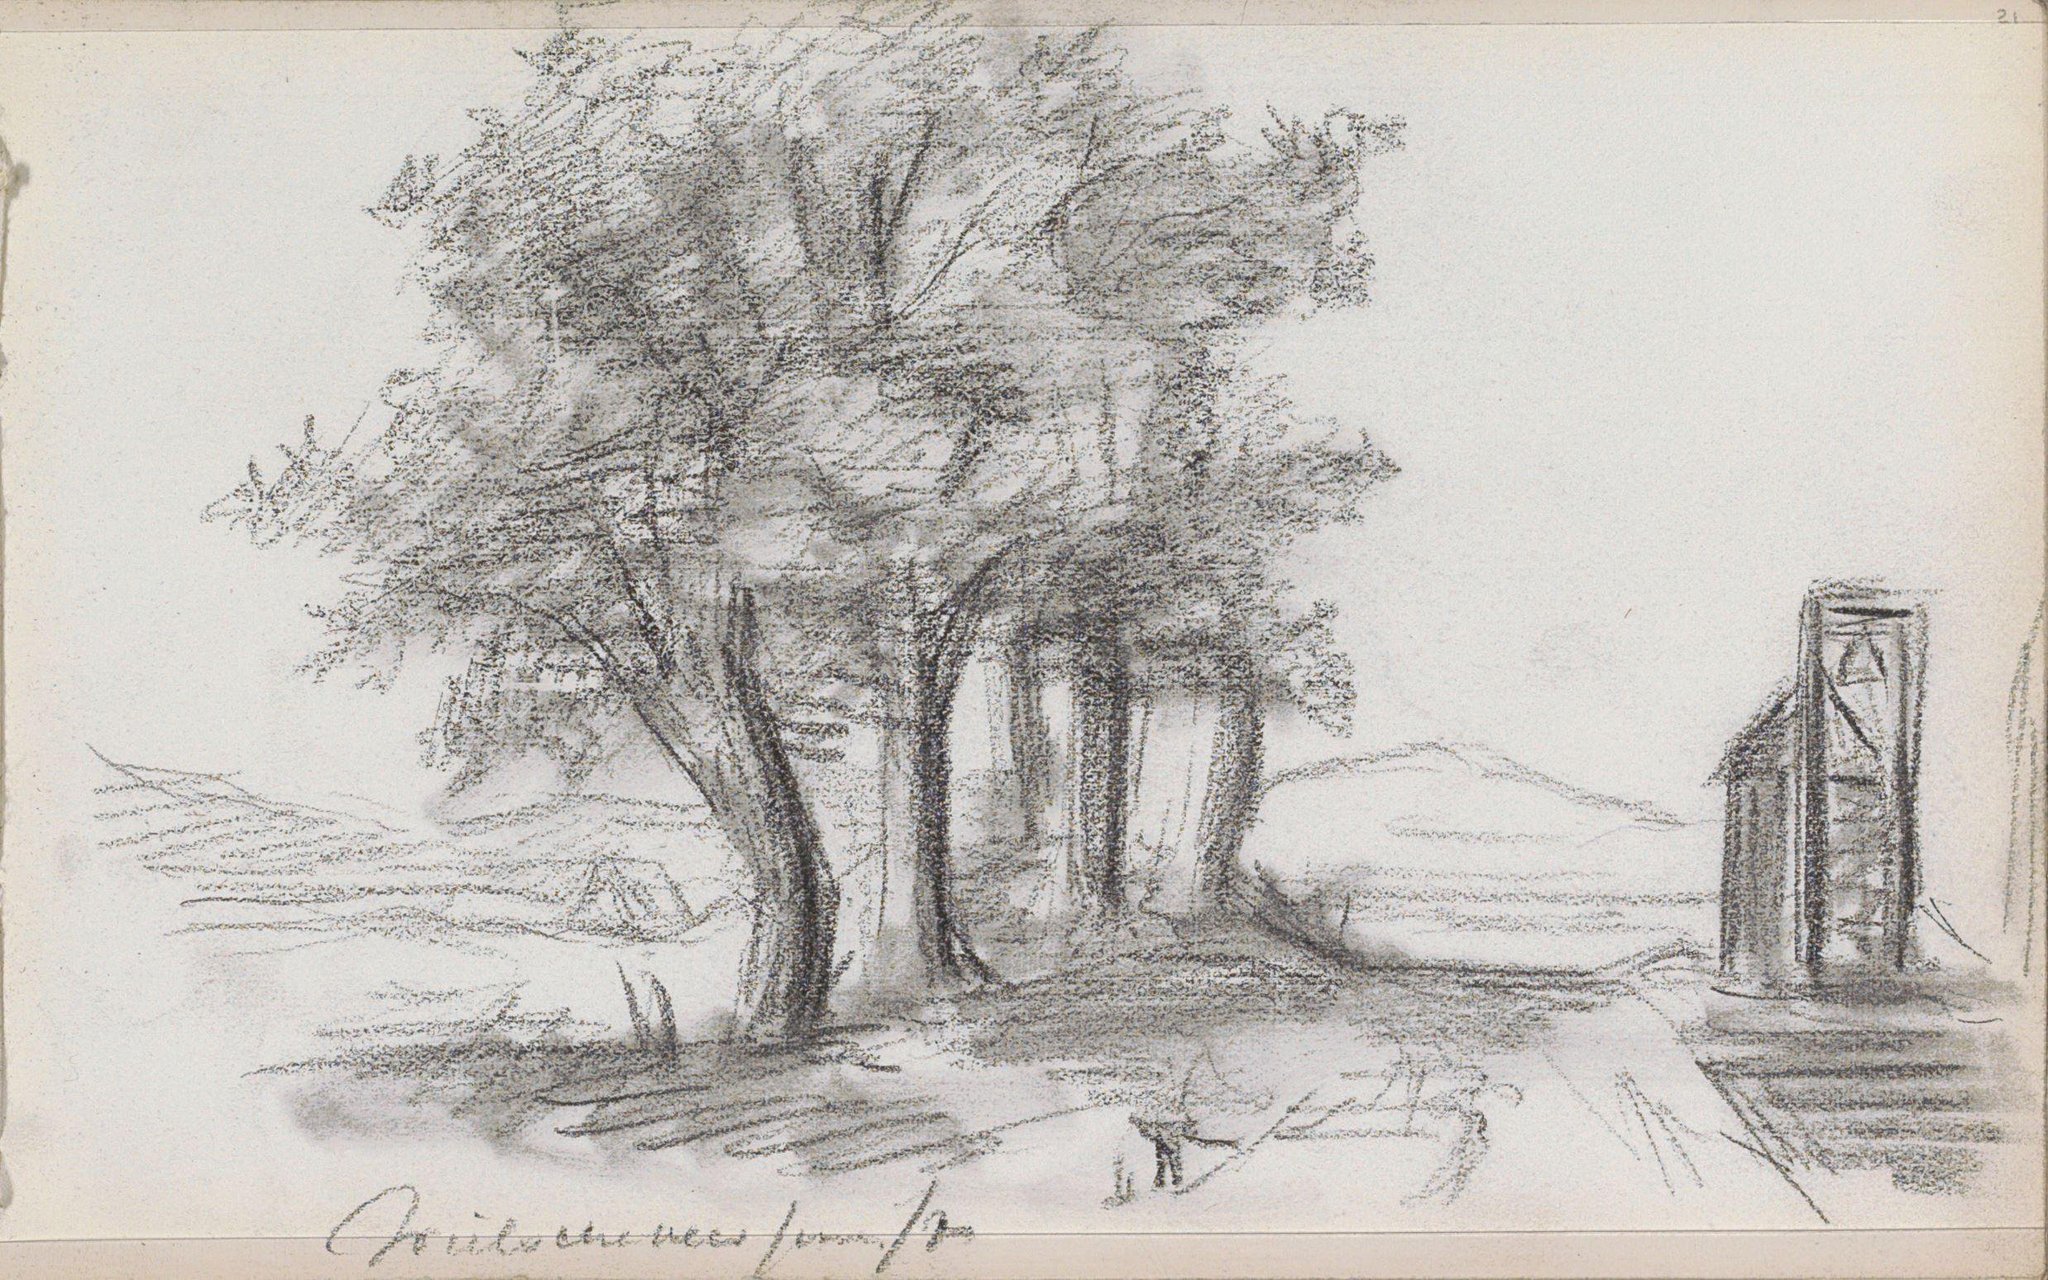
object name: sketchbook leaf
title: Gezicht op bomen langs het Wielseveer bij Eck en Wiel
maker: willem witsen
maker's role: draughtsman, painter, print maker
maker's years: 1860-1923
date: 1806-1878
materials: chalk, paper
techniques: stumping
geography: eck en wiel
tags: trees, landscapes with waters, waterscapes, seascapes (in the temperate zone)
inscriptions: annotation: ‘Wielscheveer’, date: ‘Juni 78.’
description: Pagina 21 uit een schetsboek met 23 bladen.